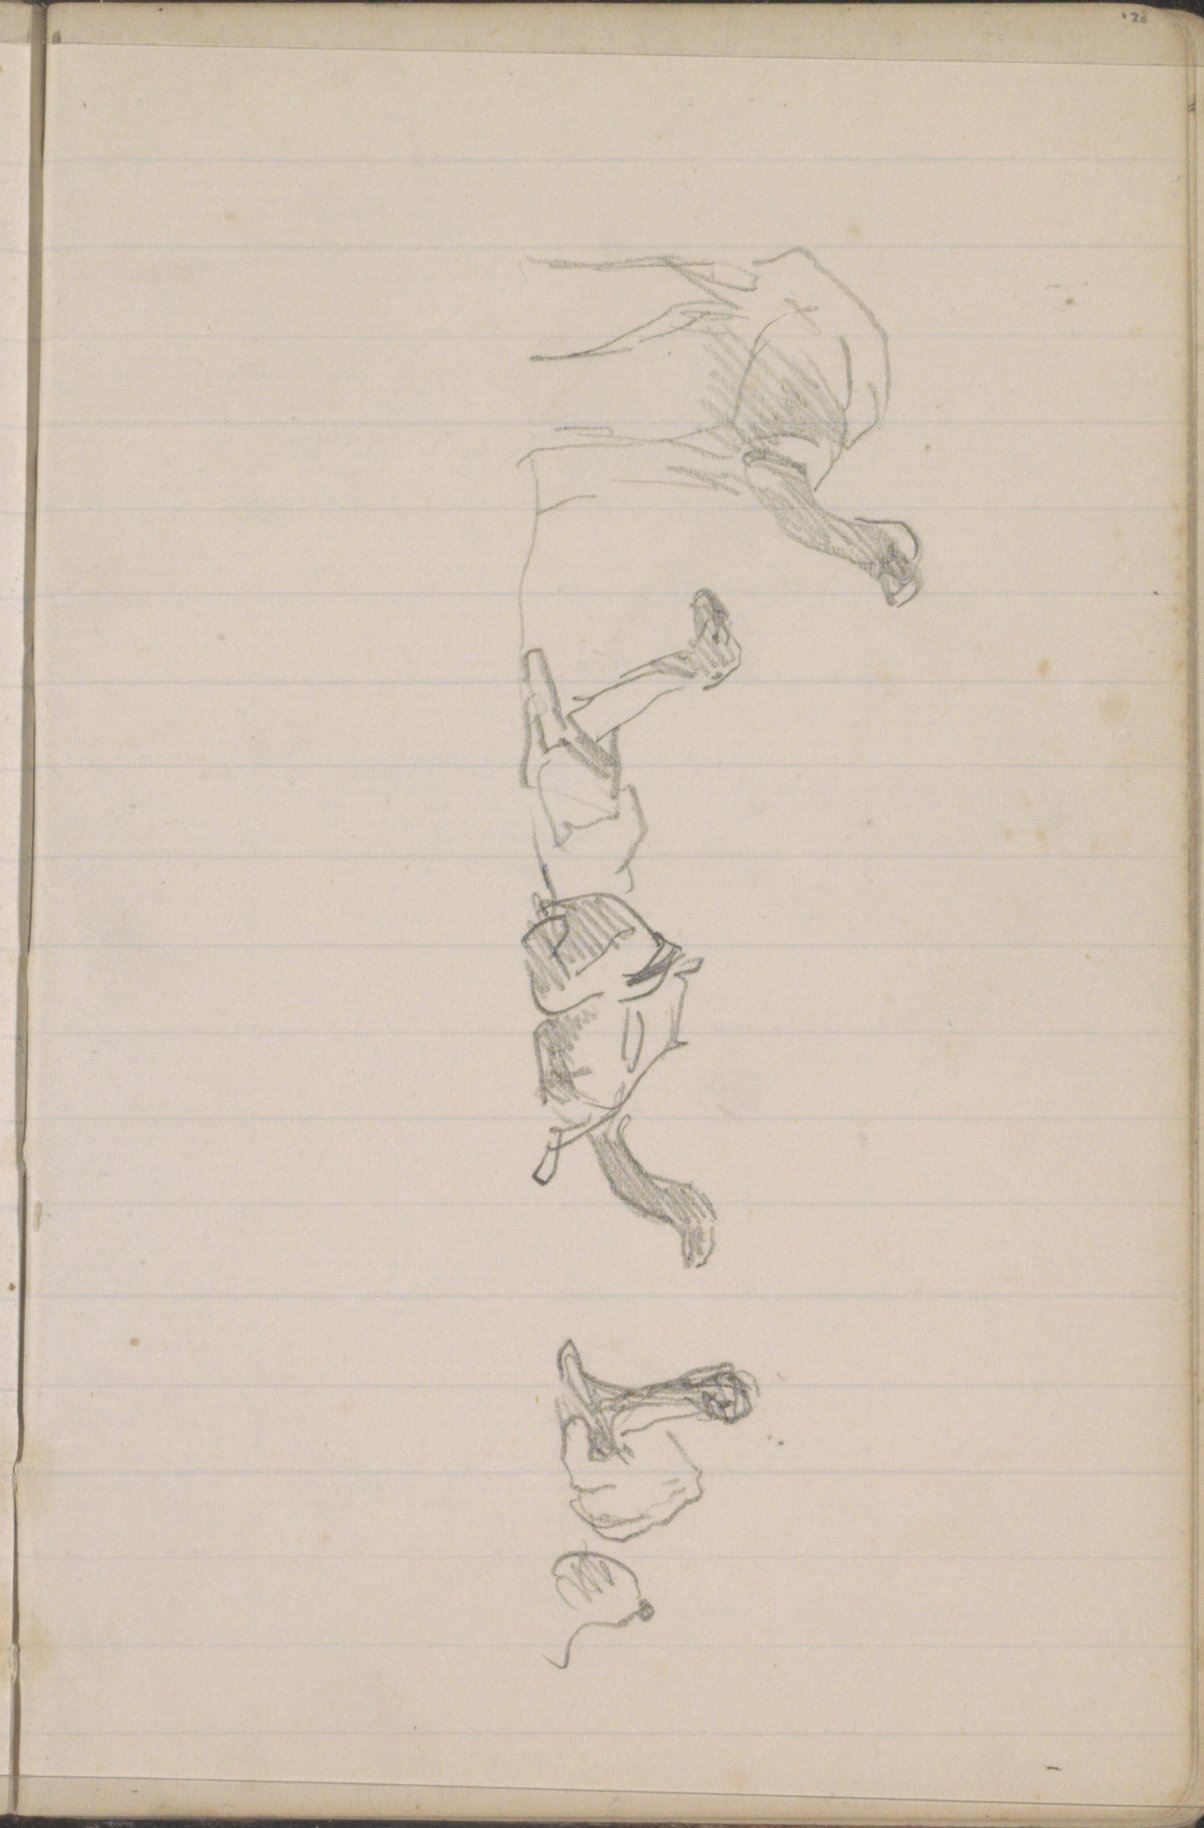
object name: sketchbook leaf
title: Staande en liggende kamelen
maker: marius bauer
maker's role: draughtsman, print maker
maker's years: 1867-1932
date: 1897-1898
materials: pencil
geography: india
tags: hoofed animals: camel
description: Pagina 128 uit een schetsboek met 84 bladen.